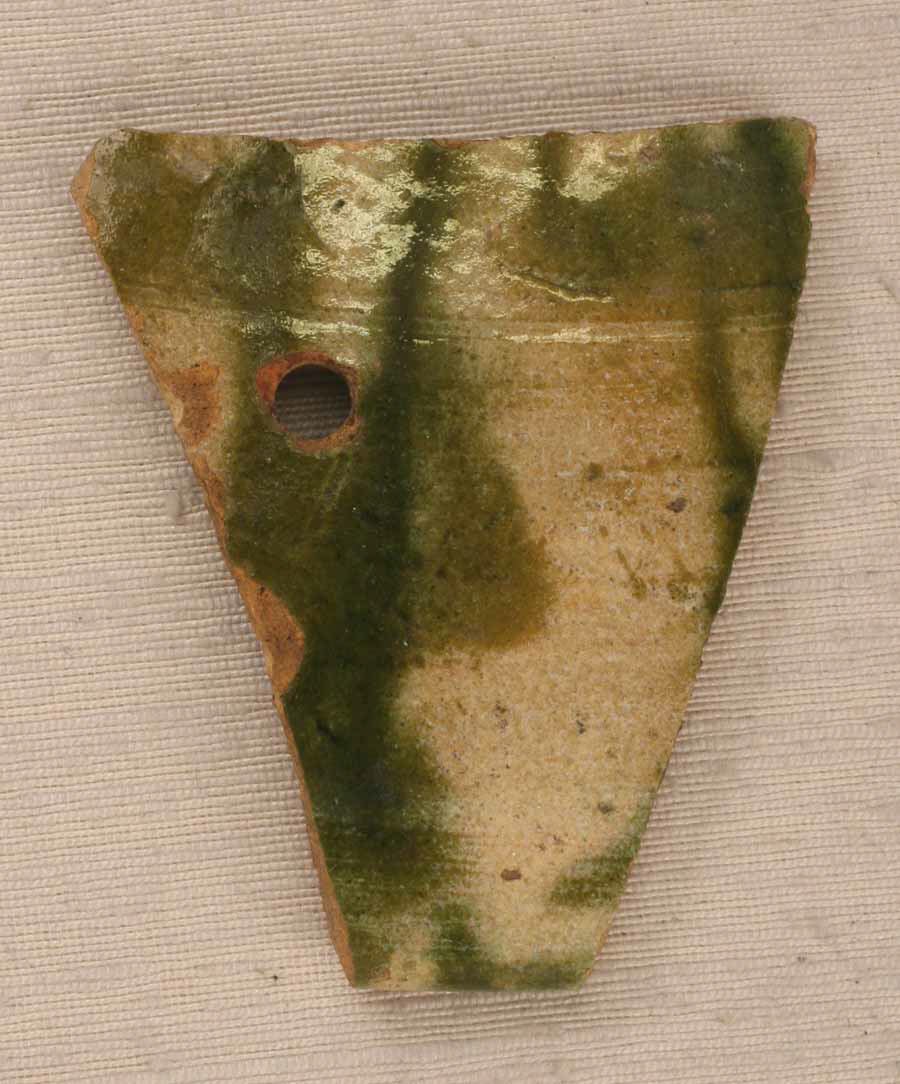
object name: fragment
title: Ceramic Fragment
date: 701-900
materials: earthenware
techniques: glazing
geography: iraq